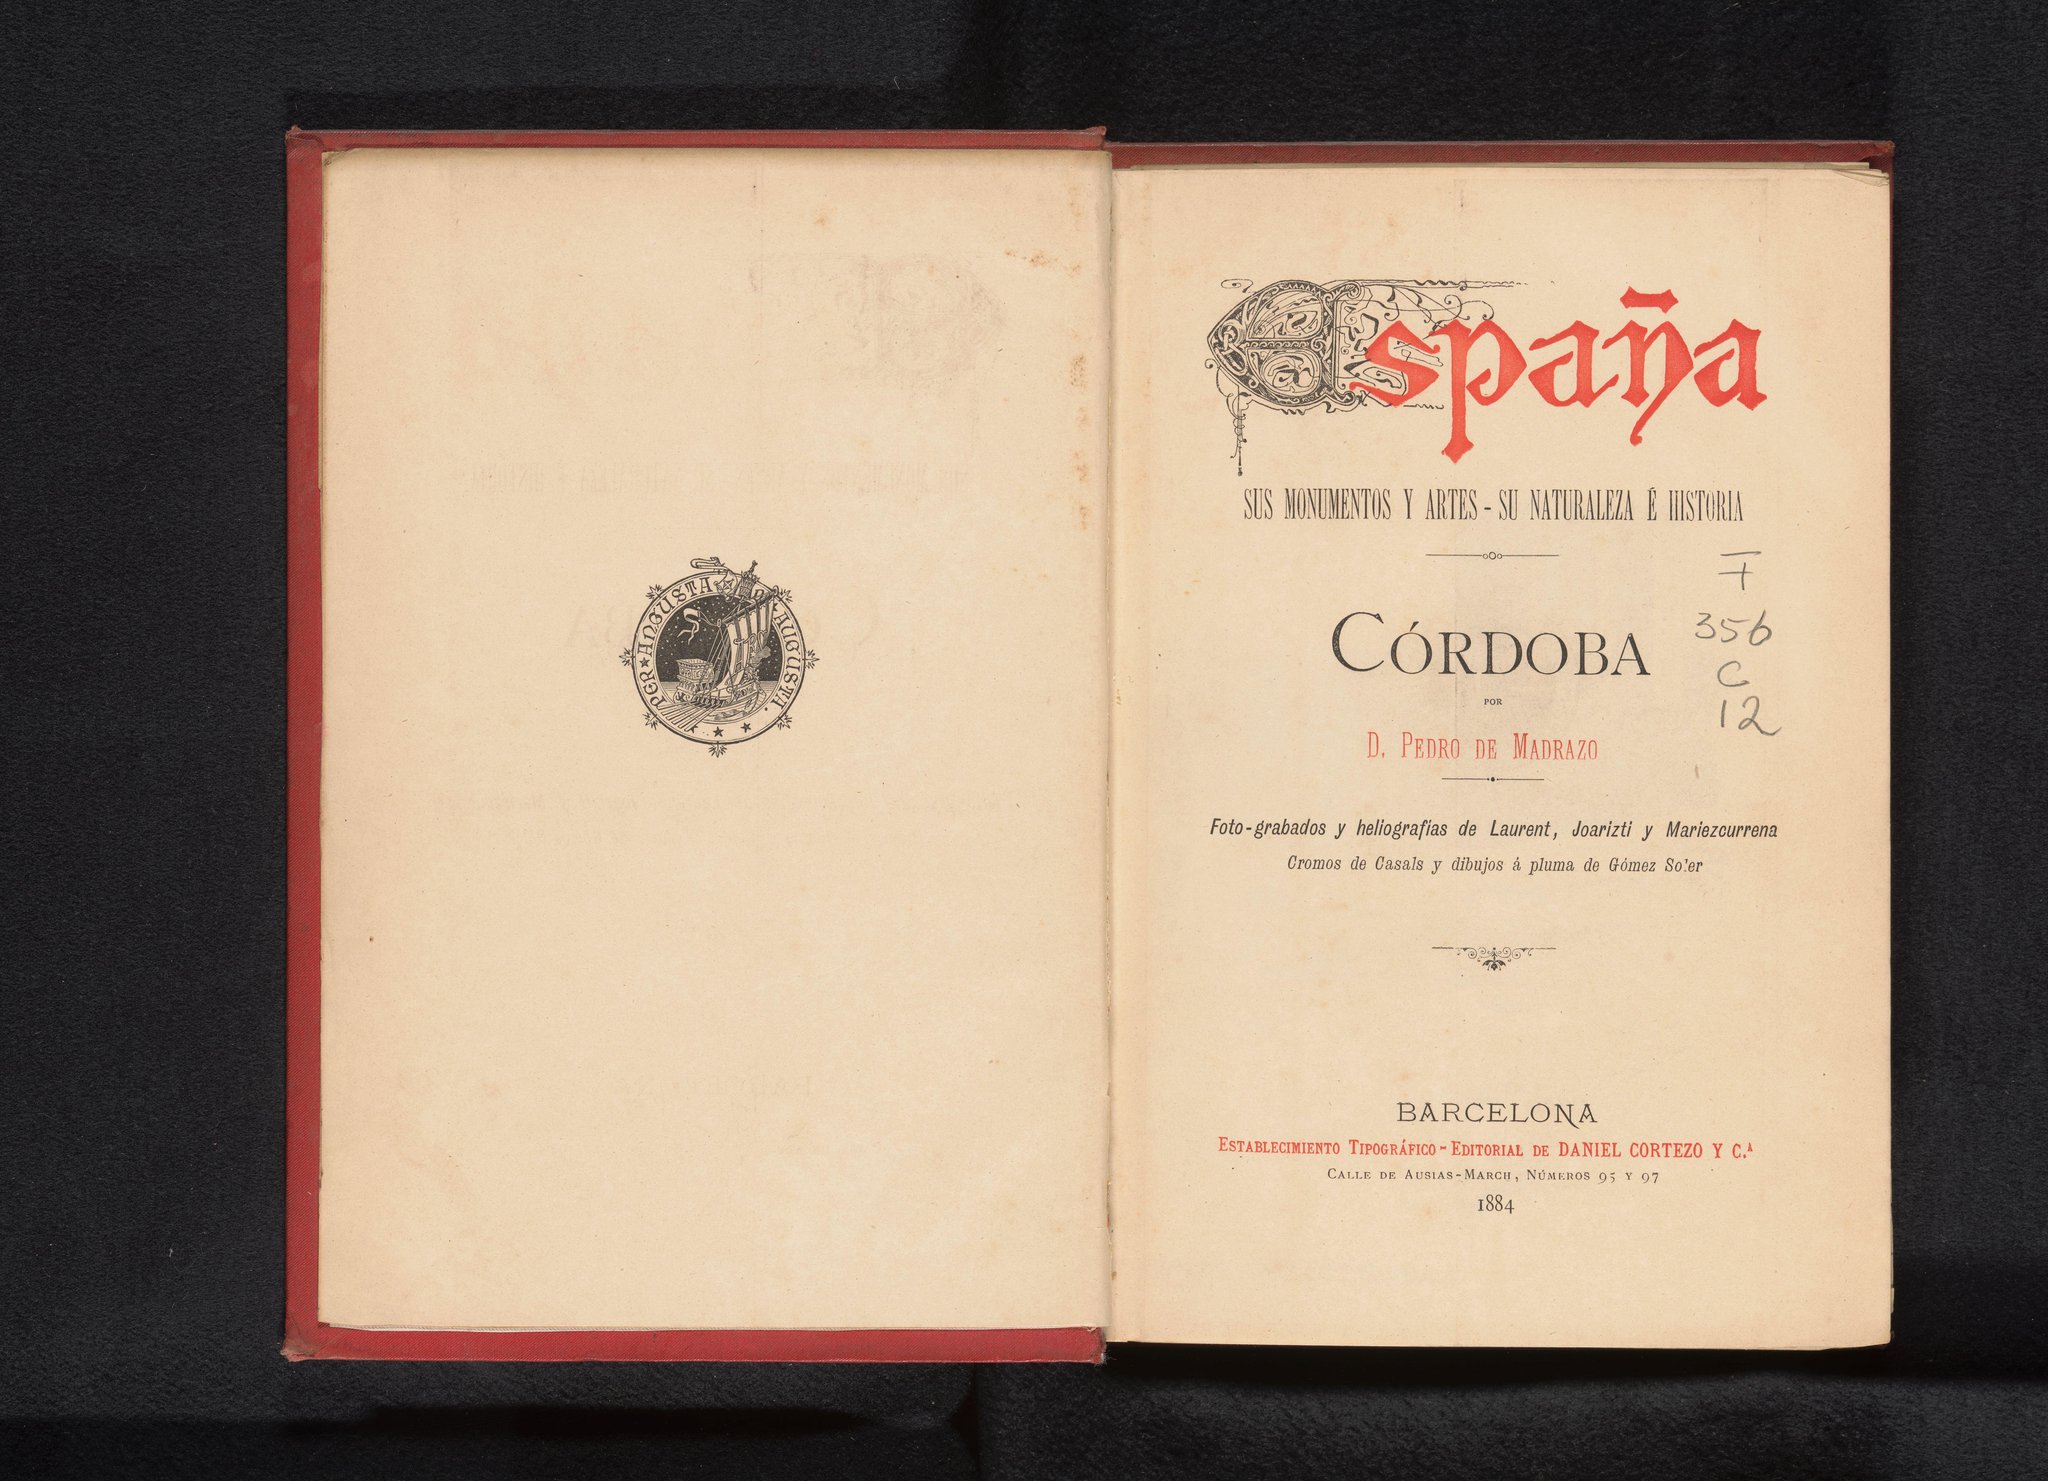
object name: book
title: Córdoba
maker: pedro de madrazo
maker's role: schrijver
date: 1884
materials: cardboard, linen, paper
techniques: photograph, lithograph, printing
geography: barcelona